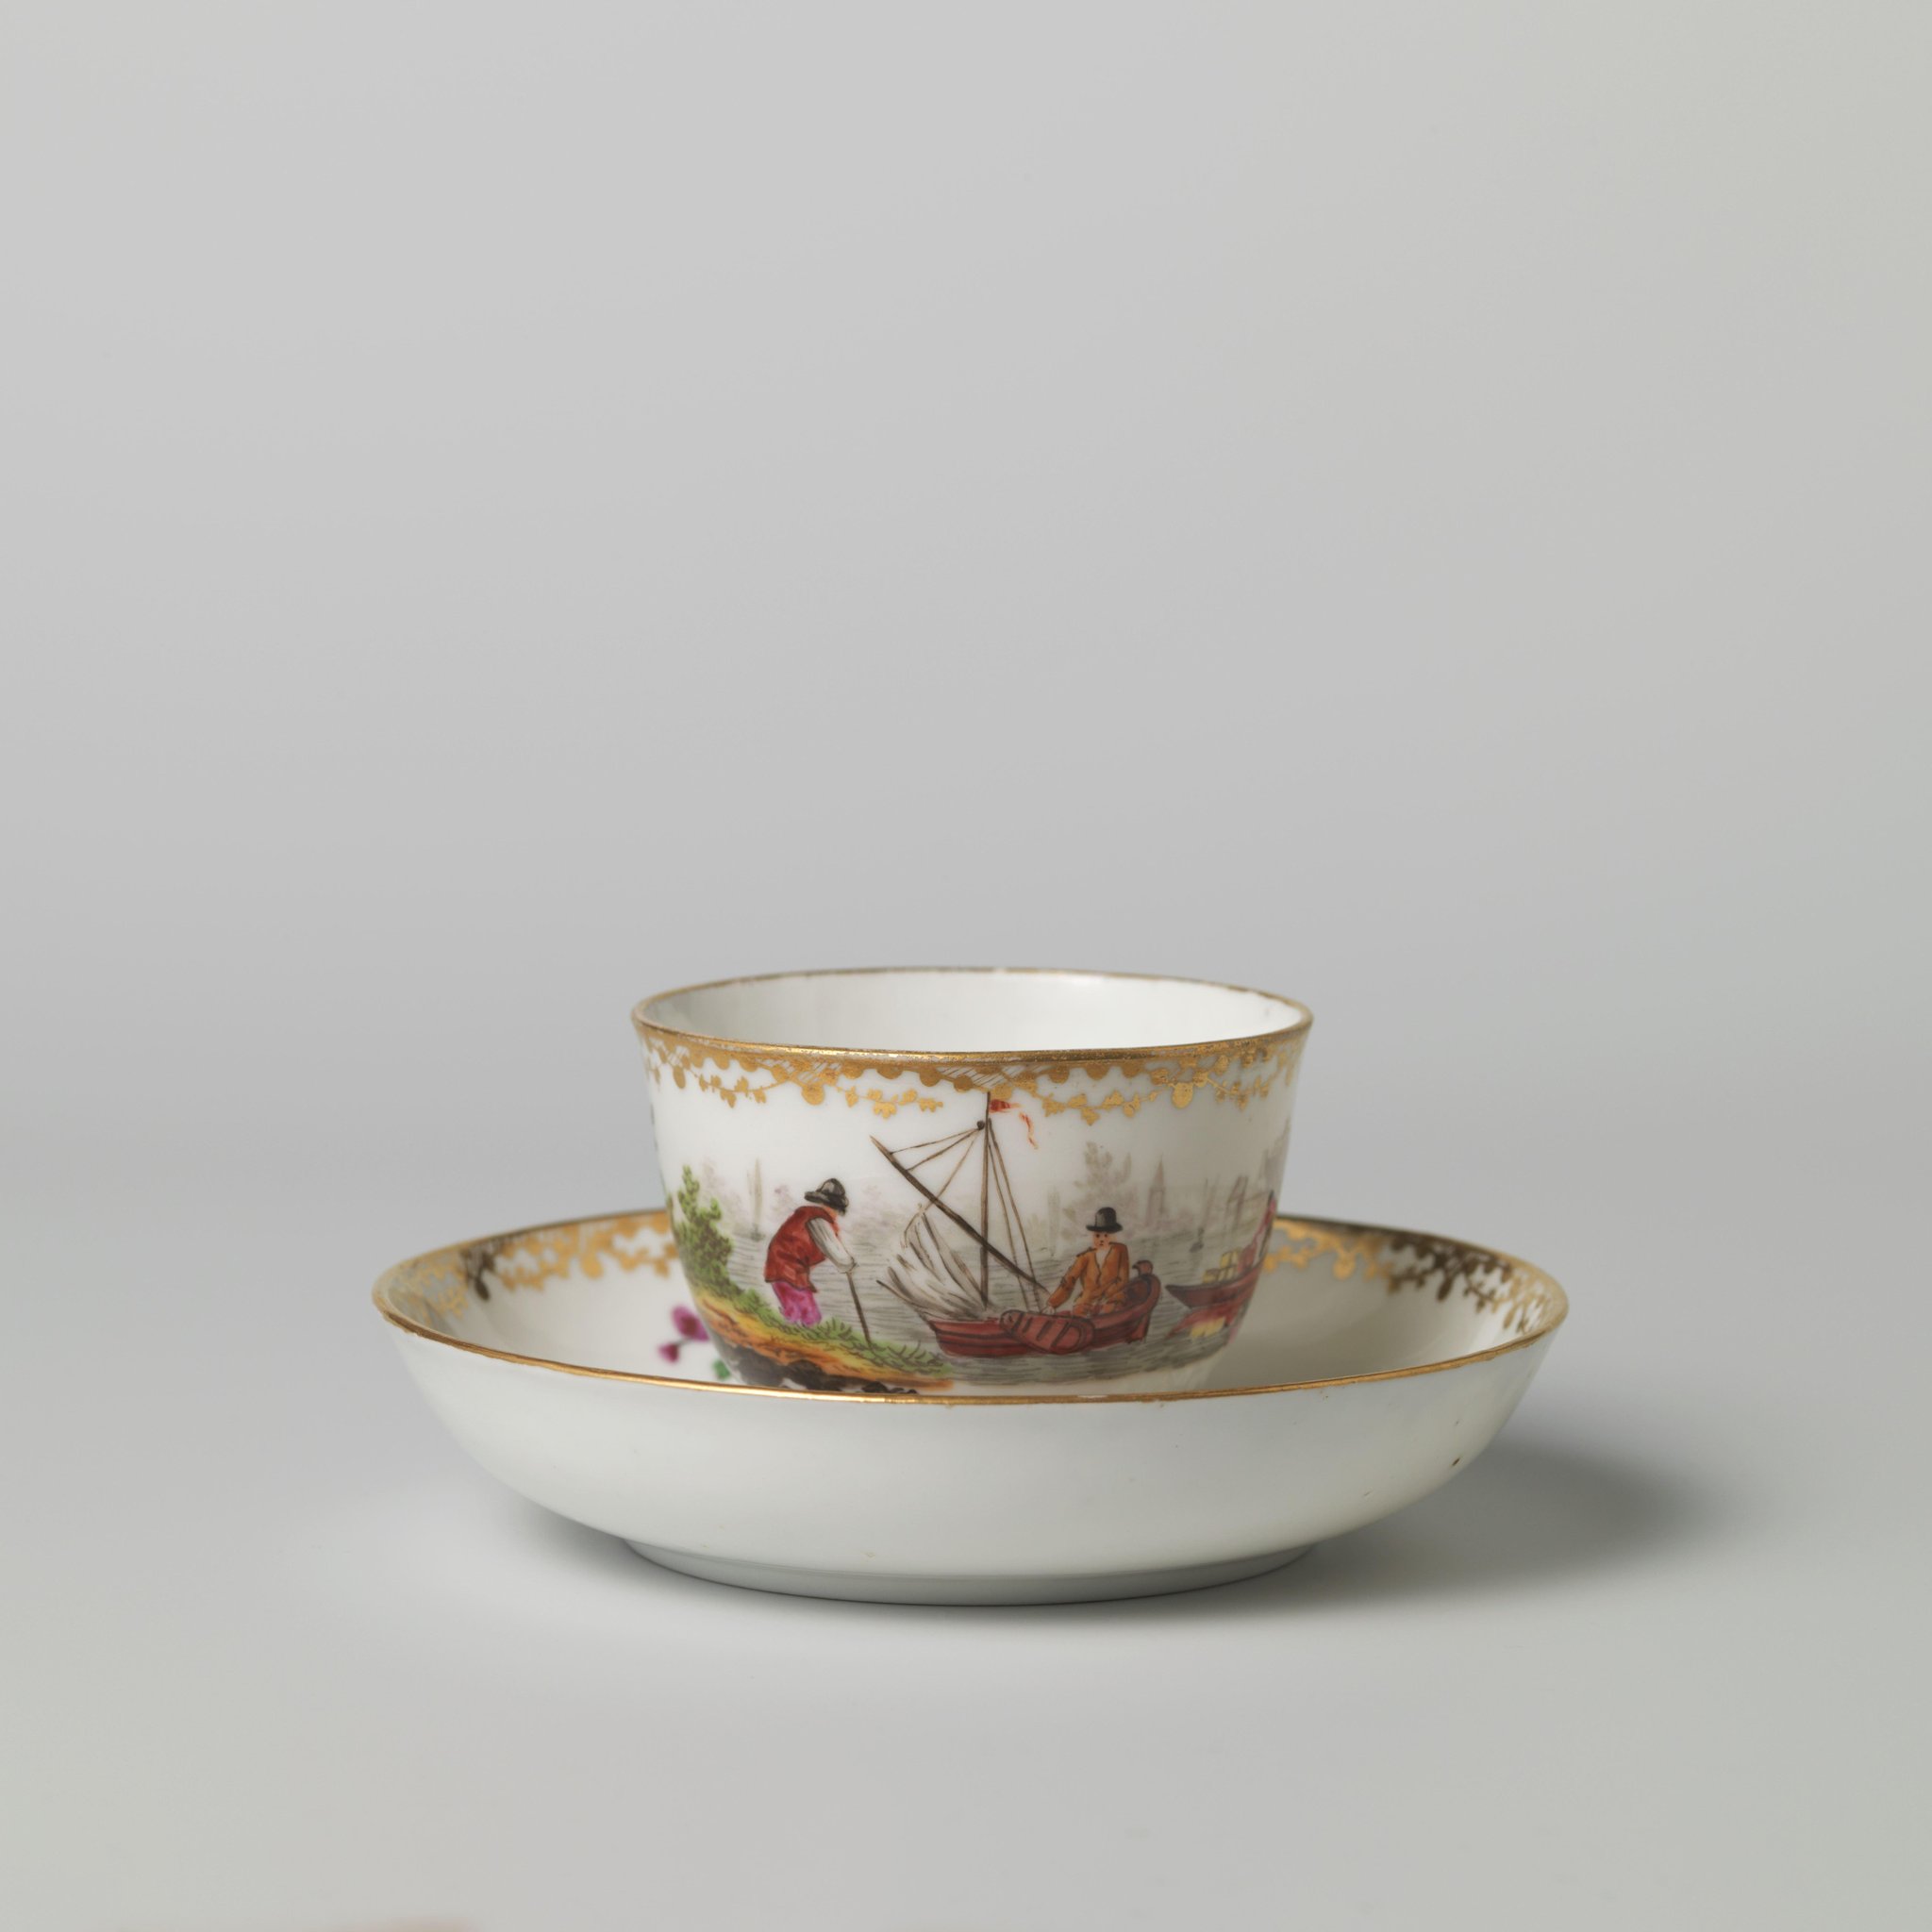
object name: cup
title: Kop, beschilderd met figuren in een waterlandschap. Bladranken langs de randen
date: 1784-1809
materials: earthenware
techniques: painted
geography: ouder-amstel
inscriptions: mark: ‘Amstel’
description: Kop veelkleurig beschilderd met figuren in een waterlandschap. Langs de randen, bladranken. Gemerkt: Amstel in zwart.